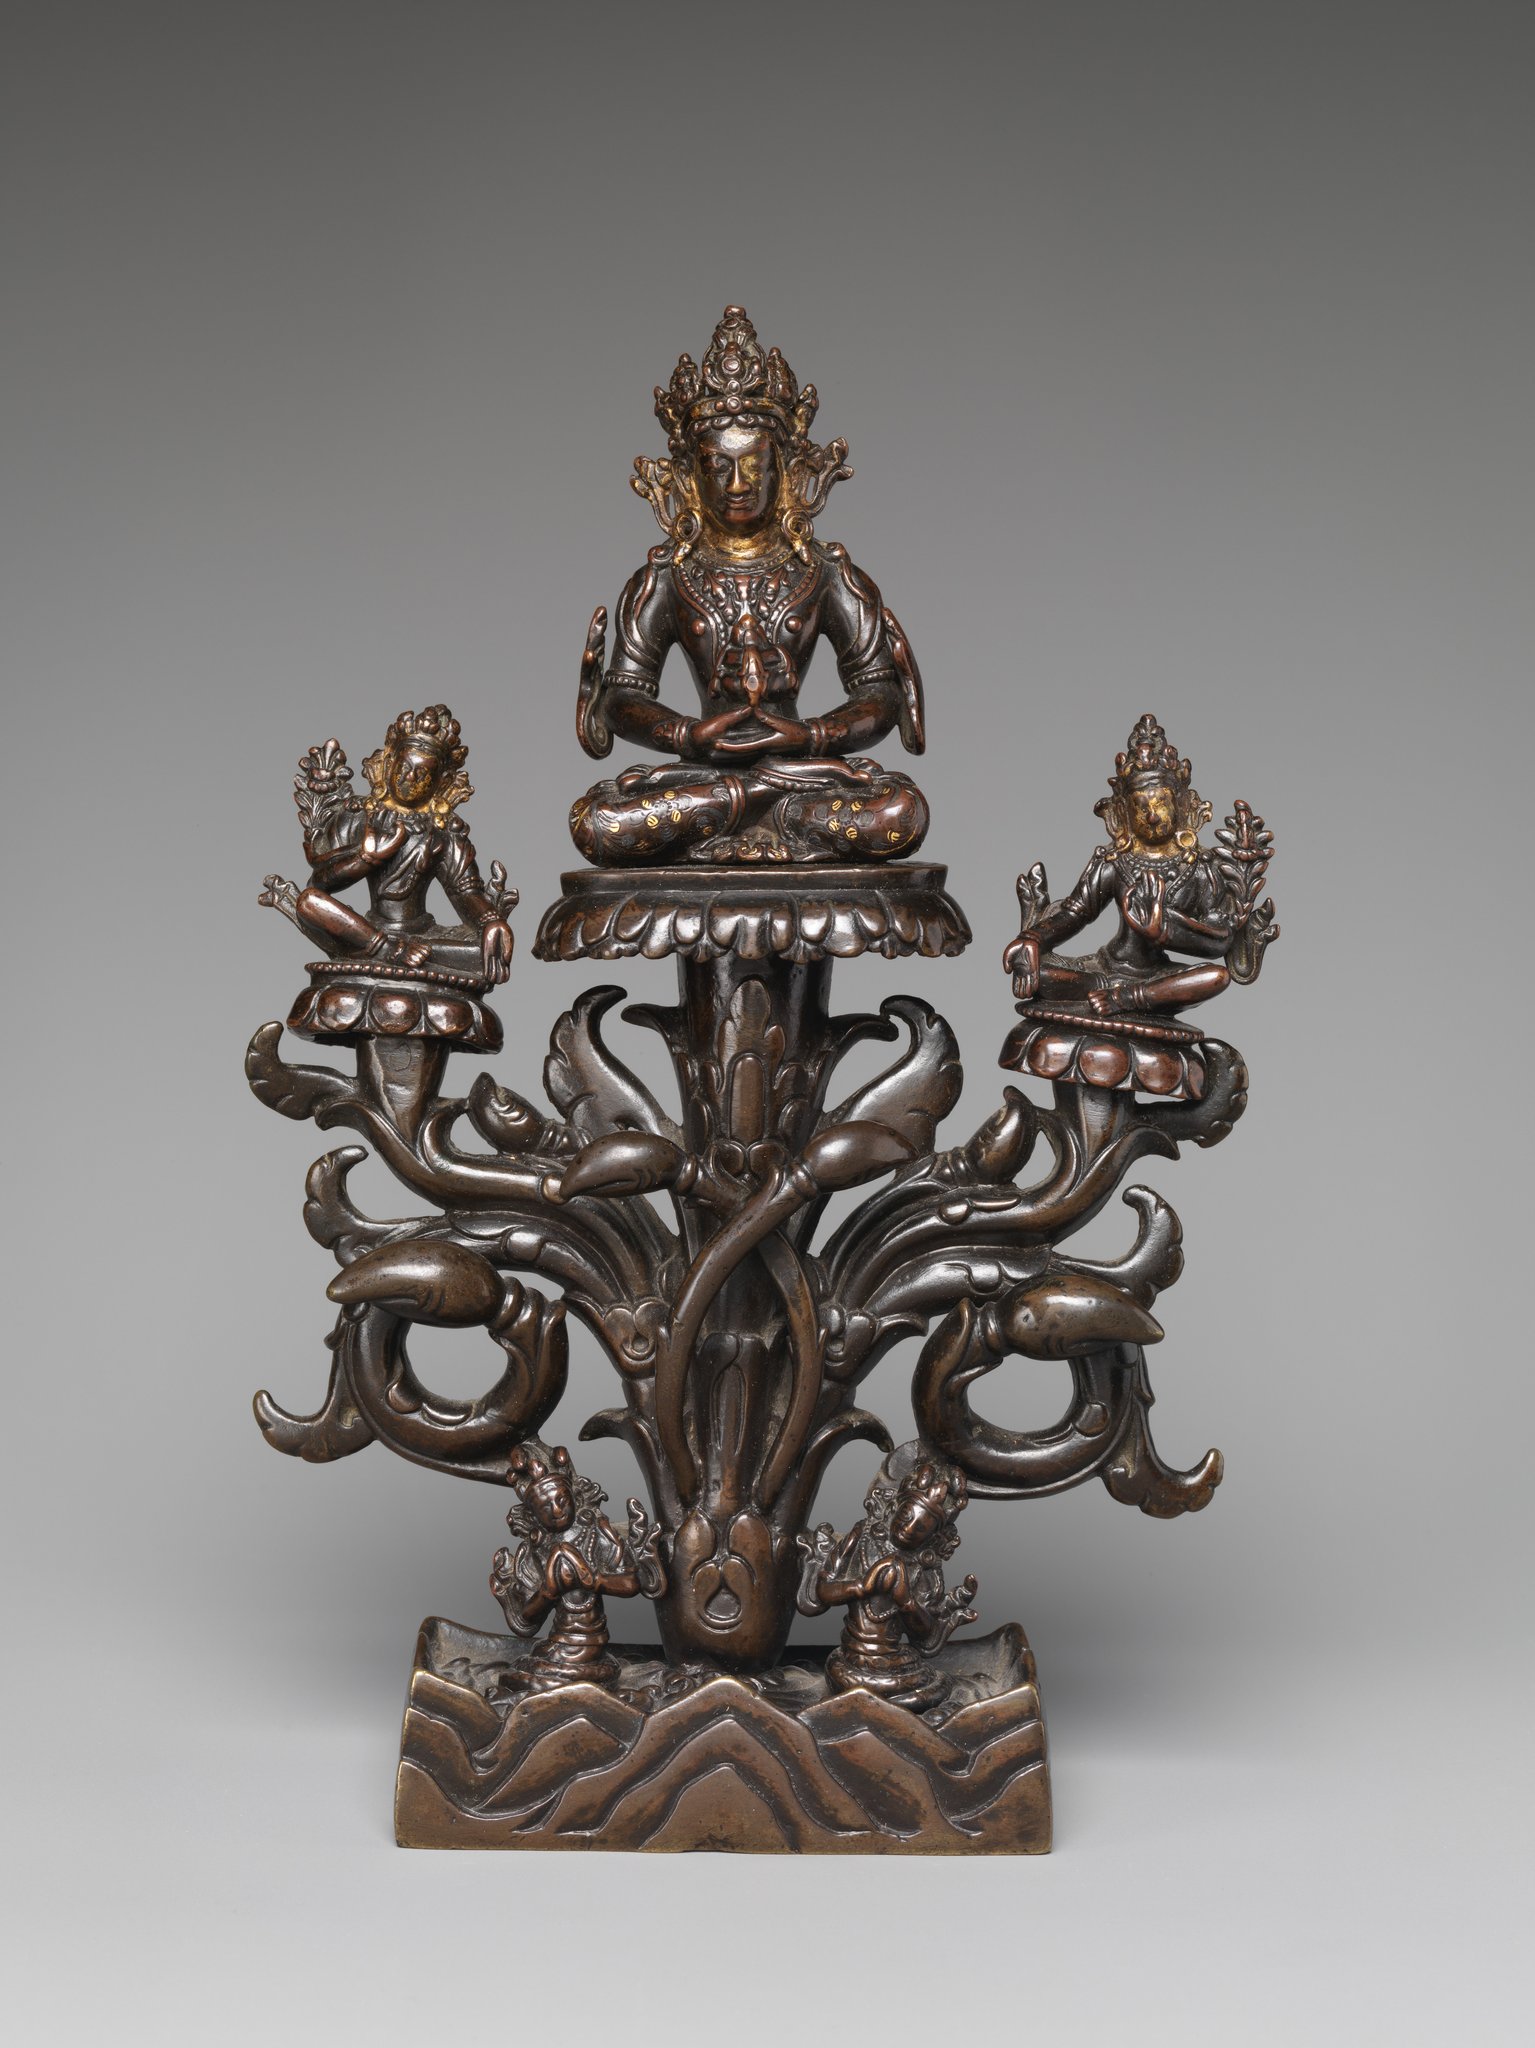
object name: figure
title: Amitayus Trinity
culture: tibetan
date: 1401-1500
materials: copper alloy, gold, gold paint, silver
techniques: inlay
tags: buddhism,bodhisattvas,deities